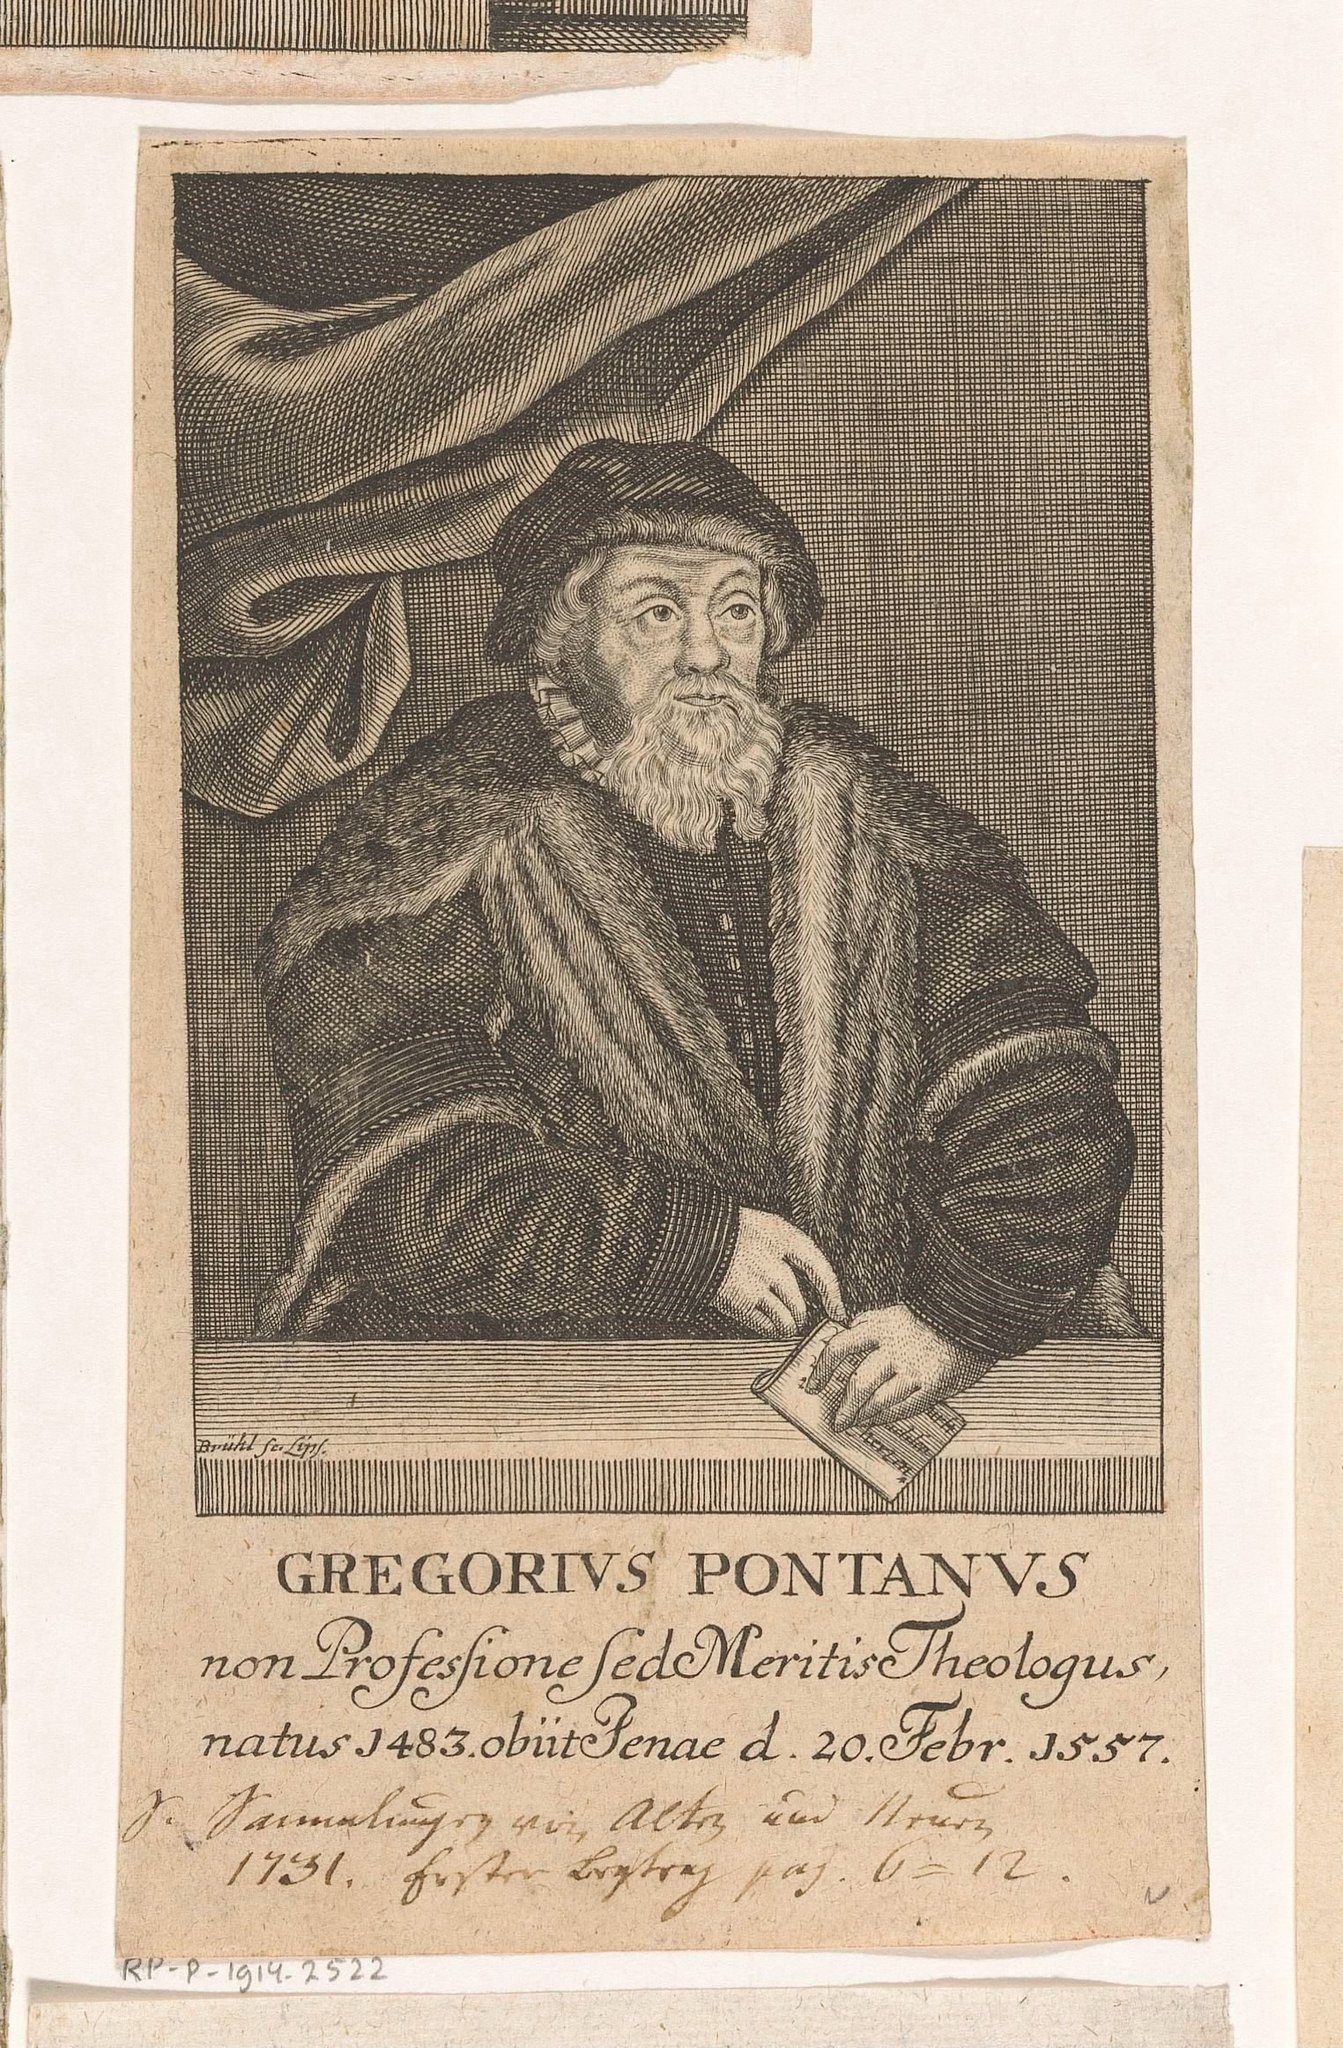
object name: print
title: Portret van Gregor Brück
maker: johann benjamin brühl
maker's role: print maker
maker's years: 1691-1763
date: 1731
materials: paper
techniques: engraving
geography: leipzig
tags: historical persons, letter, envelope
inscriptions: collector's mark: Lugt 2228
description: Prent ook gebruikt in: Fortgesetzte Sammlung Von Alten und Neuen Theologischen Sachen (...) Auf das Jahr 1731. Leipzig: erven Johann Friedrich Braun.